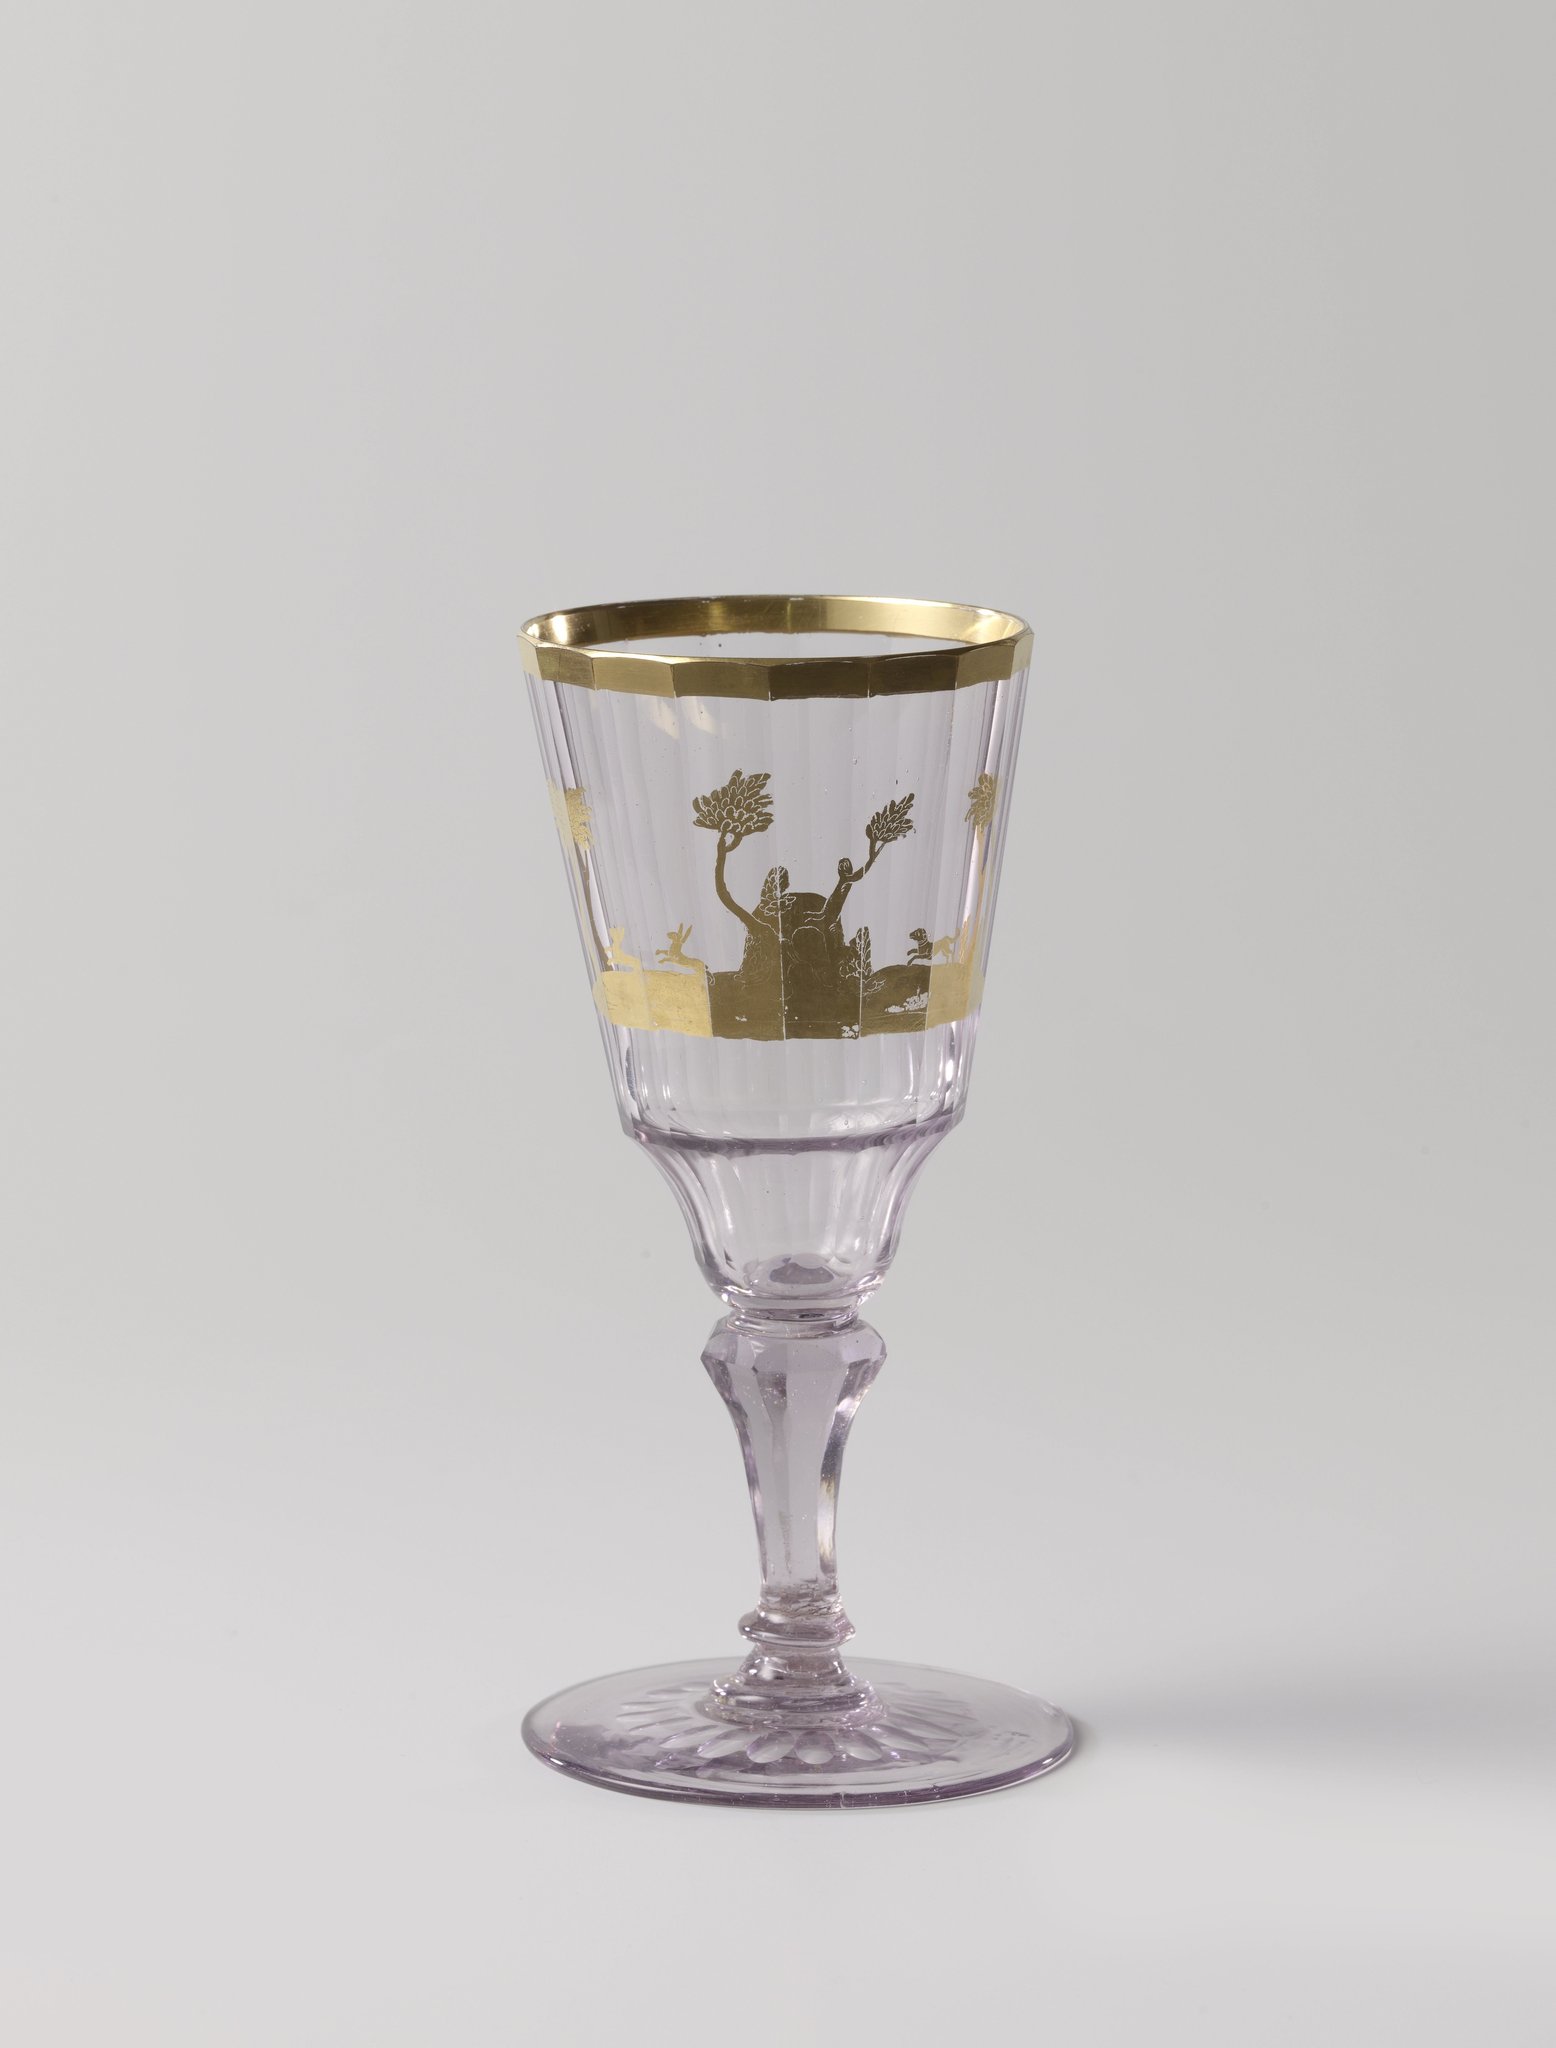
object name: goblet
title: Kelkglas met twee konijnen en een hond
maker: Anonymous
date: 1725-1749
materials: glass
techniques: gilding, glassblowing, grinding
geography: bohemia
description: Conische voet met geslepen decoratie van ellipsen op de onderzijde. In facetten geslepen, balustervormige stam met één schijf. Trechtervormige, in facetten geslepen kelk met concaaf gebogen onderzijde. Op de kelk in verguldsel twee konijnen en een hond in een landschap. Langs de bovenrand van de kelk een gouden bies.